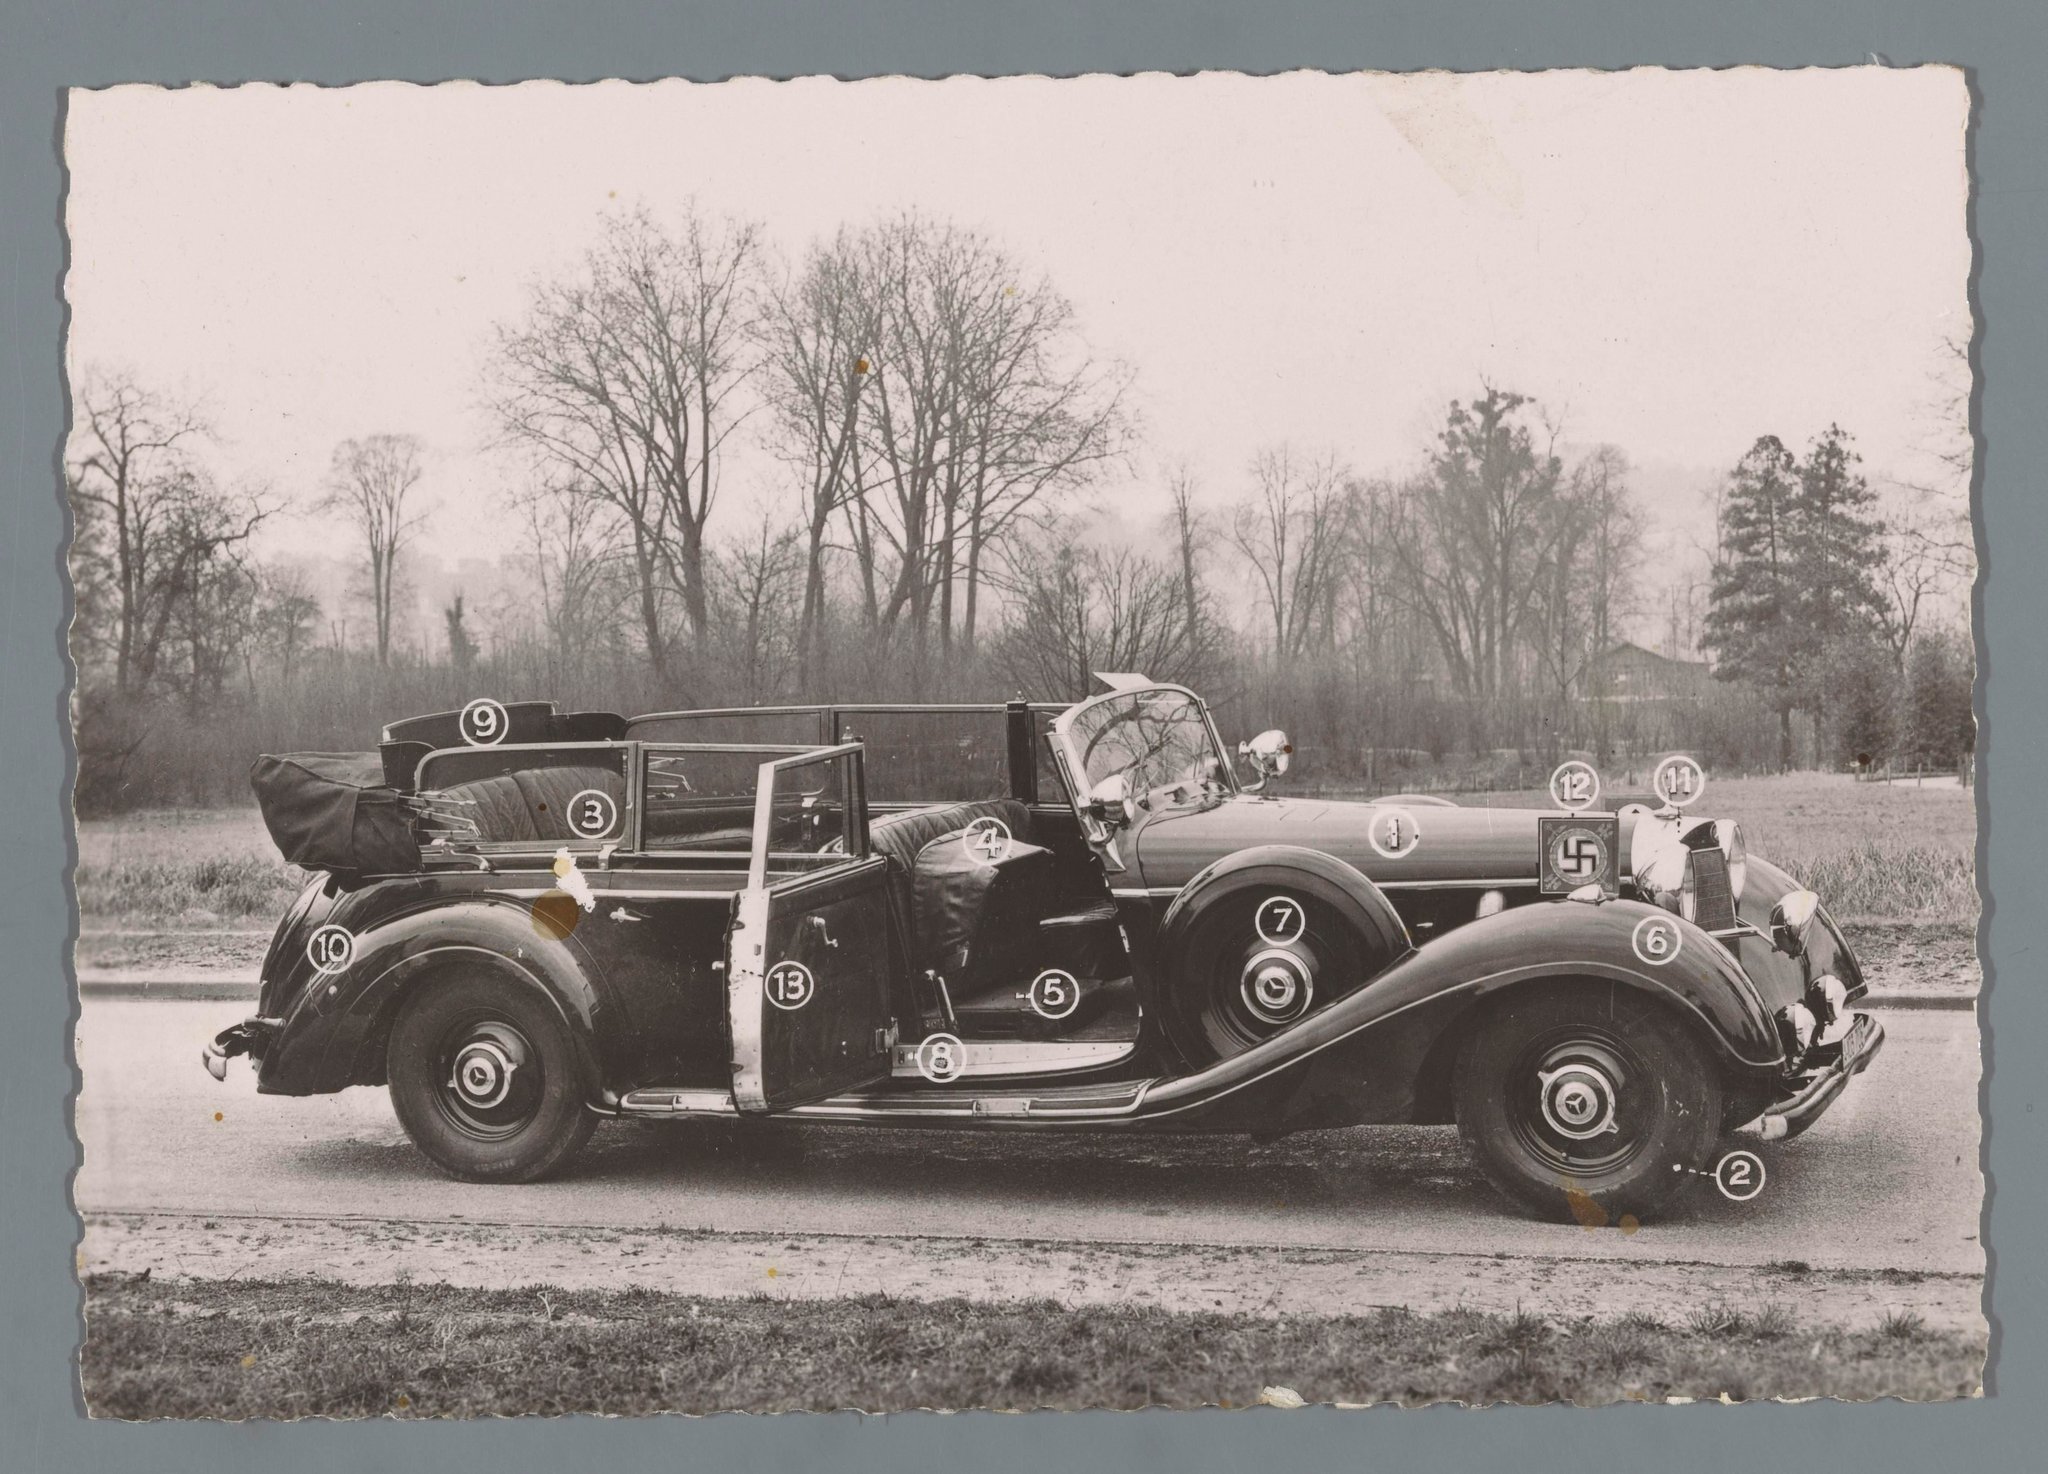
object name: photograph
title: Paradewagen van Adolf Hitler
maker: Anonymous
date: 1942-1952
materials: photographic support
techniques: gelatin silver print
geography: paris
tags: automobile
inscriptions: inscription: ‘Hitler's personal parade car Manufactured in 1942 Weight when empty: 4780 kgs (...) gehele blindering van 18m/m dikte’